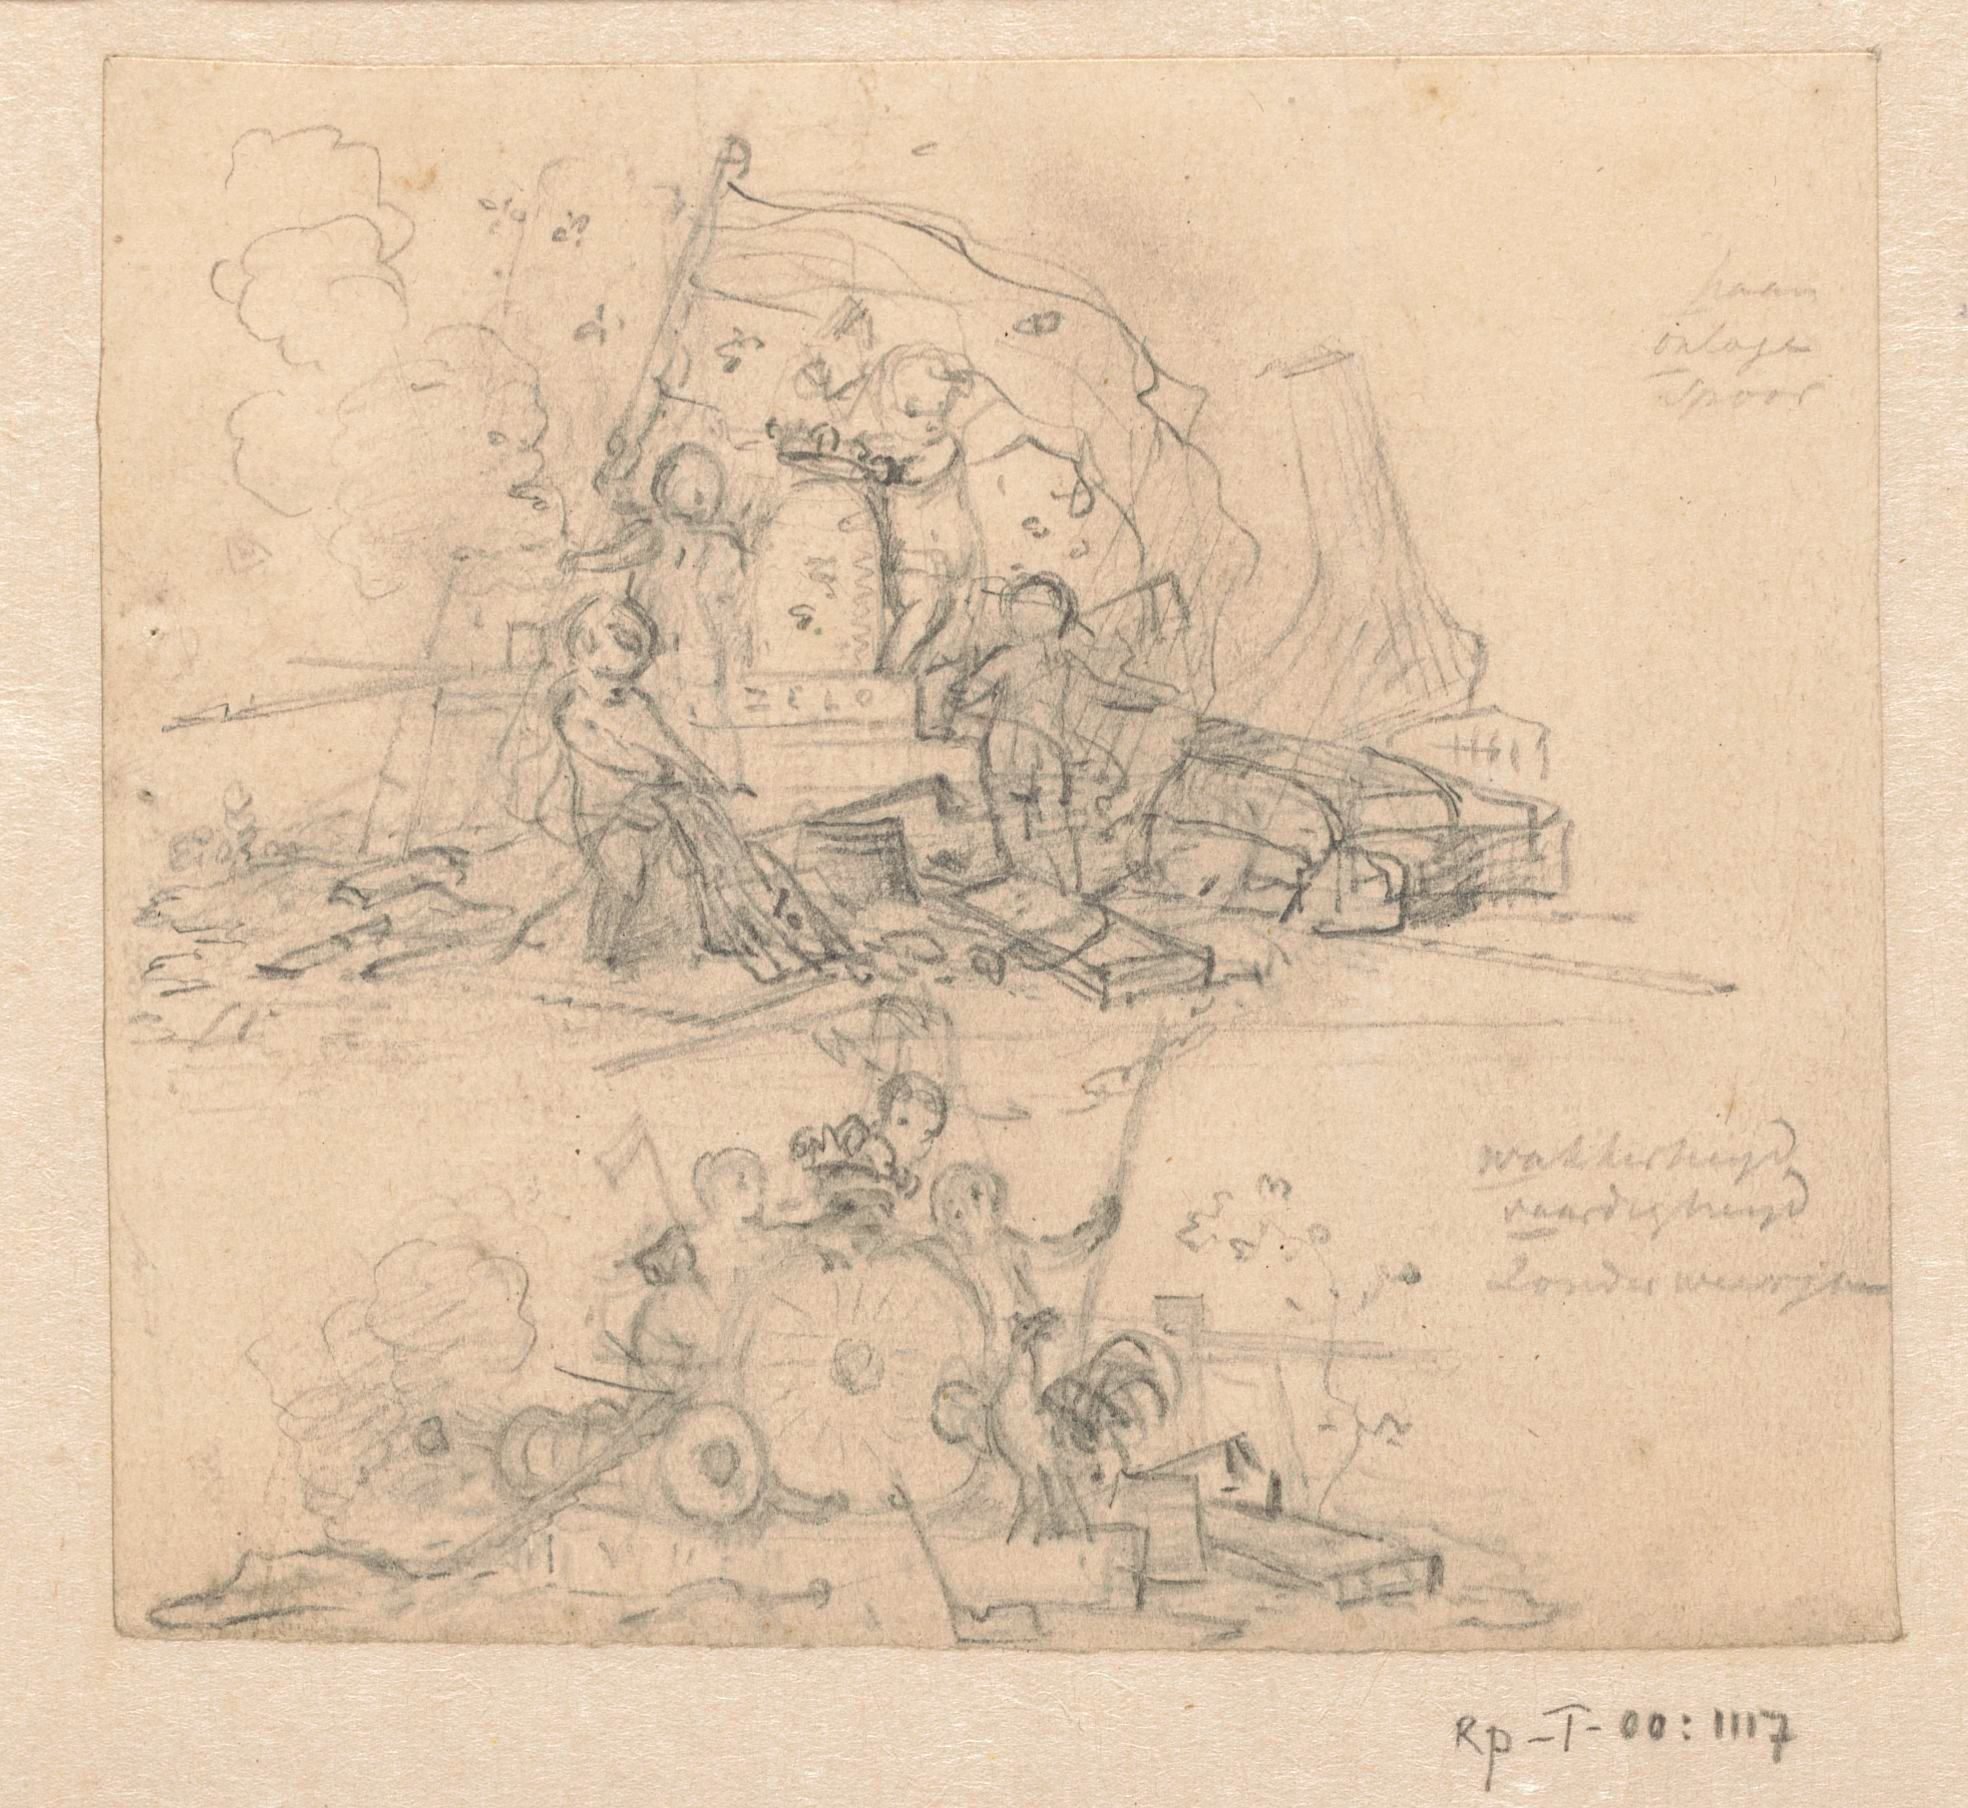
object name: drawing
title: Twee schetsen van putti bij symbolen met betrekking tot de VOC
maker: jurriaan andriessen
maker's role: draughtsman, painter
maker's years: 1742-1819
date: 1752-1819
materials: graphite, paper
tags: organization of trade and finance, names of organizations, companies, trade unions, etc., trade, commerce and finance, 'navigatione' (ripa)